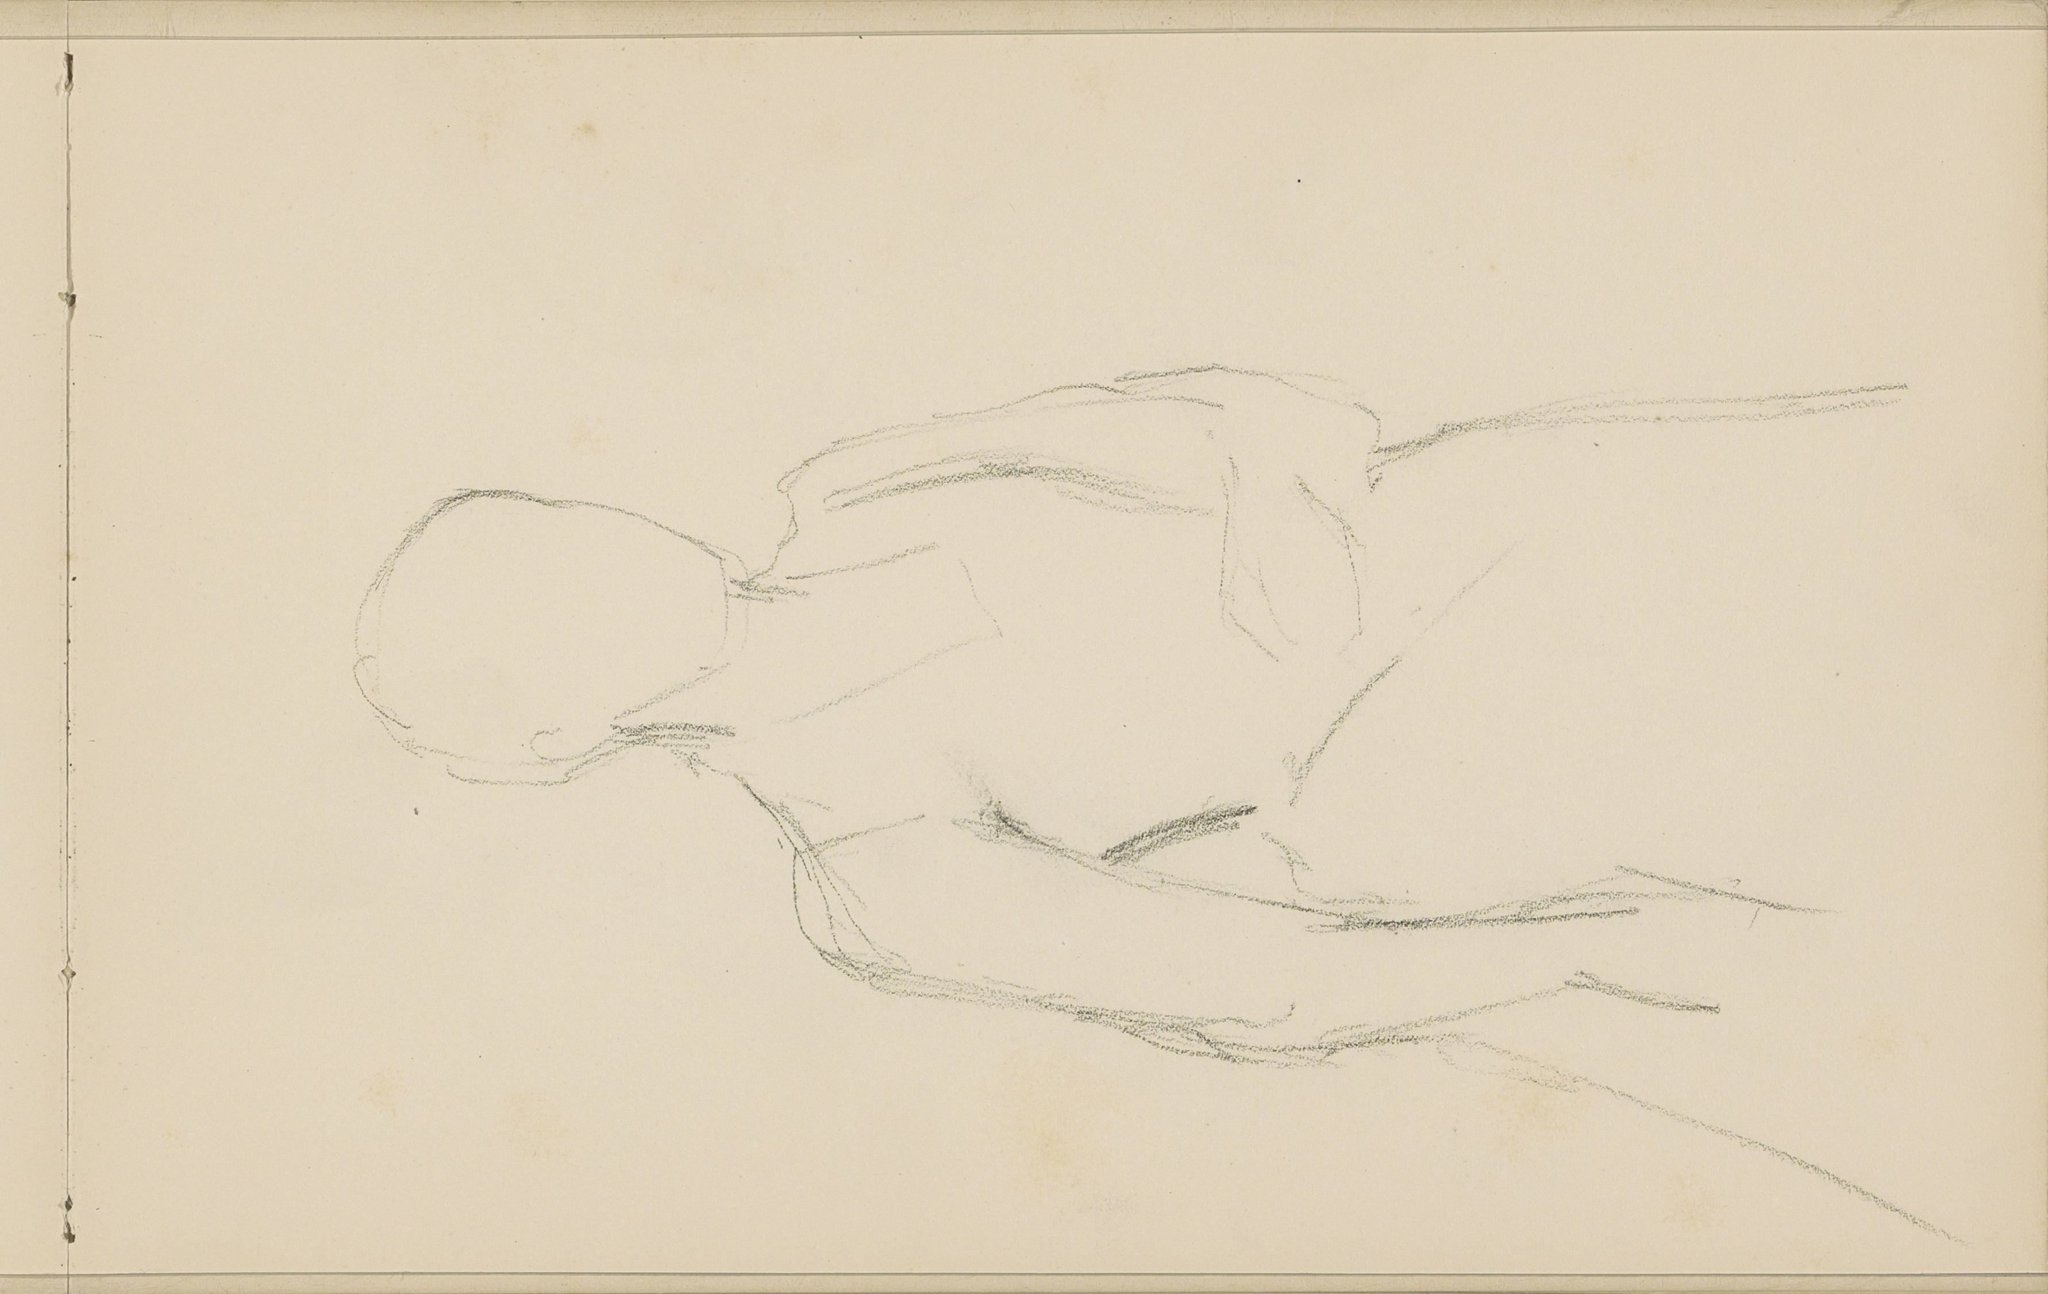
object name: sketchbook leaf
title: Vrouw in een lange jurk, ten halven lijve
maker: a.a.l. de grammont-hubrecht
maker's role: draughtsman, painter, print maker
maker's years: 1855-1913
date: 1865-1913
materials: chalk, paper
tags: adult woman, dress, gown (+ women's clothes)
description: Blad 5 recto uit een schetsboek met 65 bladen.